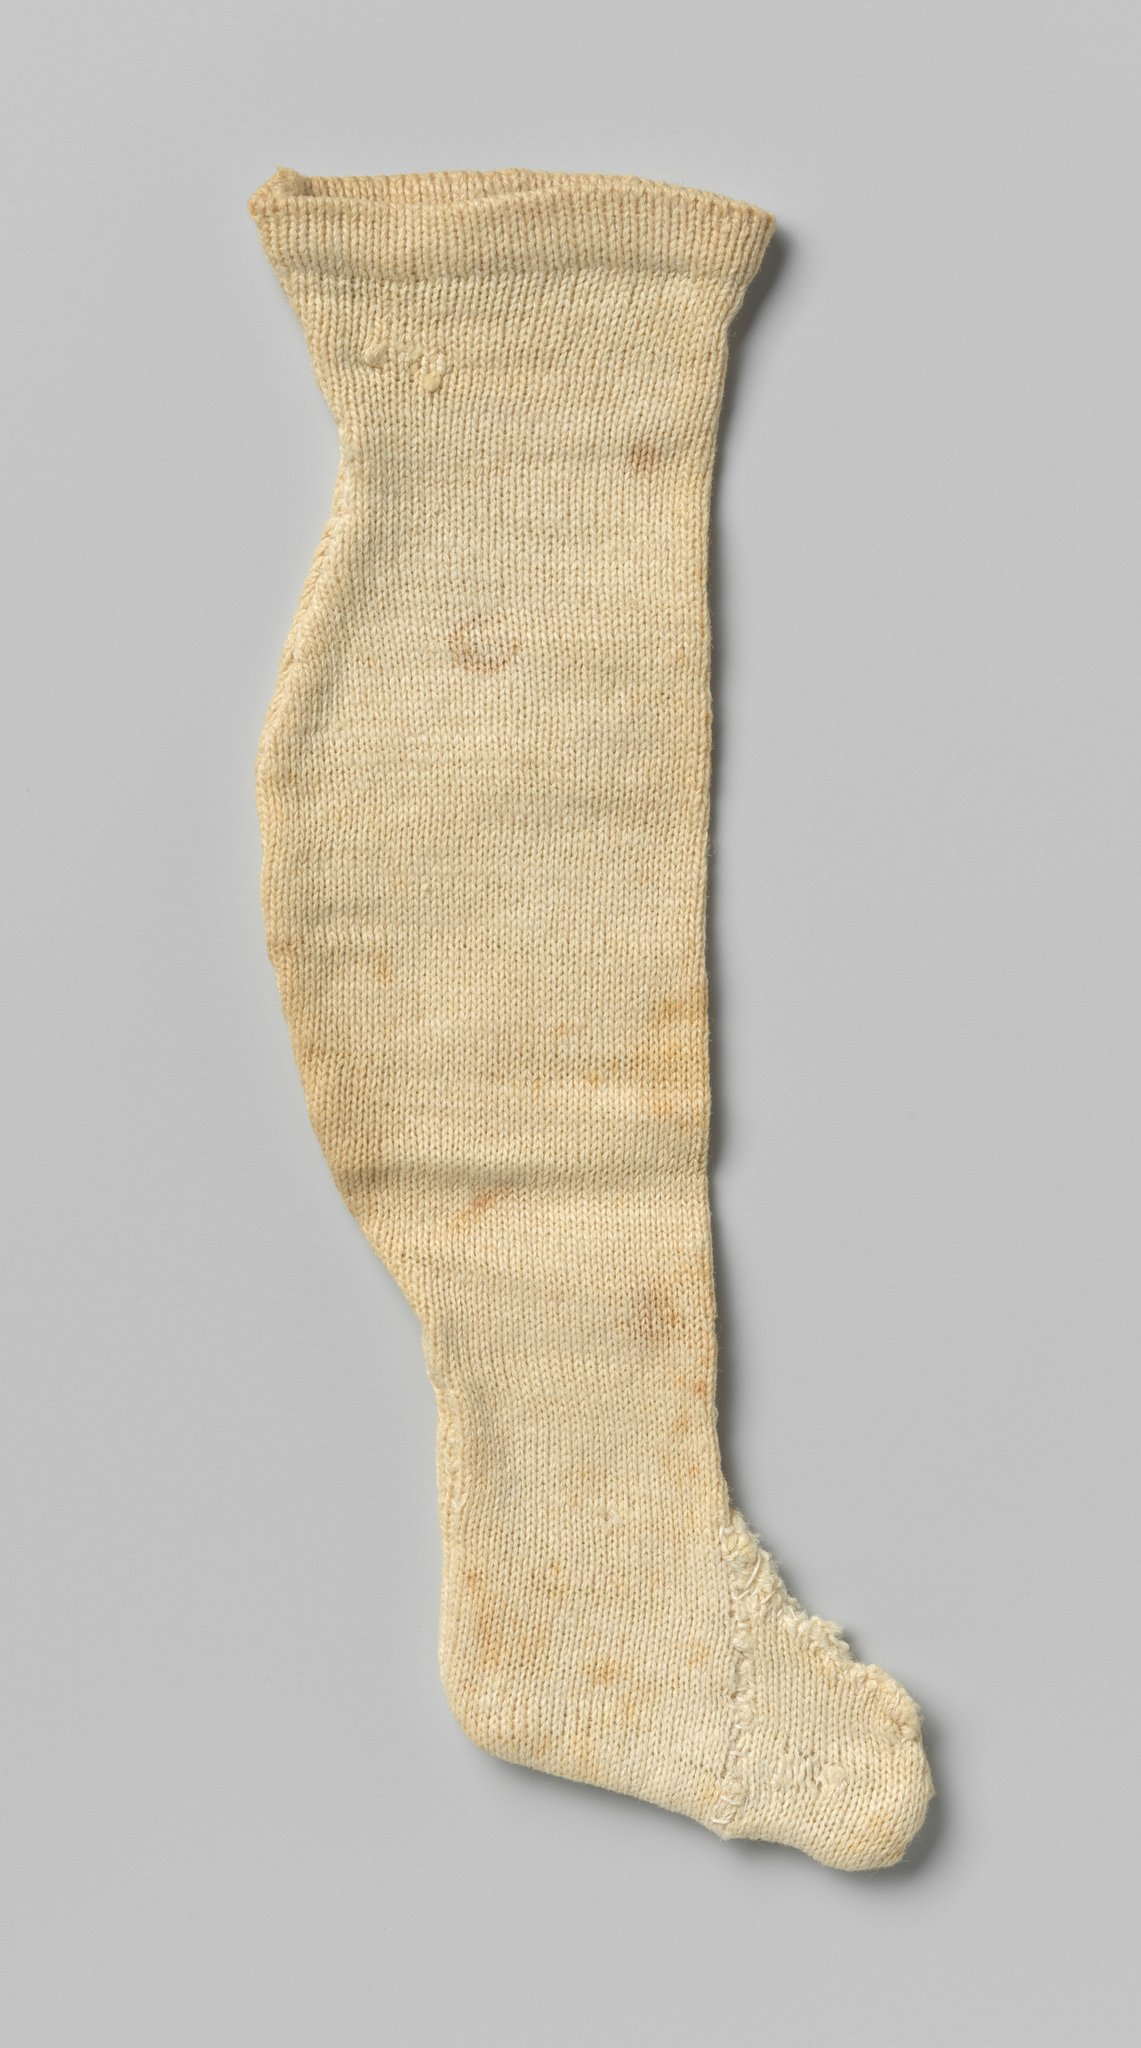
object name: stocking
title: Kous van wit gebreid textiel, deel van een paar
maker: Anonymous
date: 1790-1810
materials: cotton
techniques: knitting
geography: europe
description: Onderdeel van set poppengoed met mand, drie doeken, paar kousen en po.